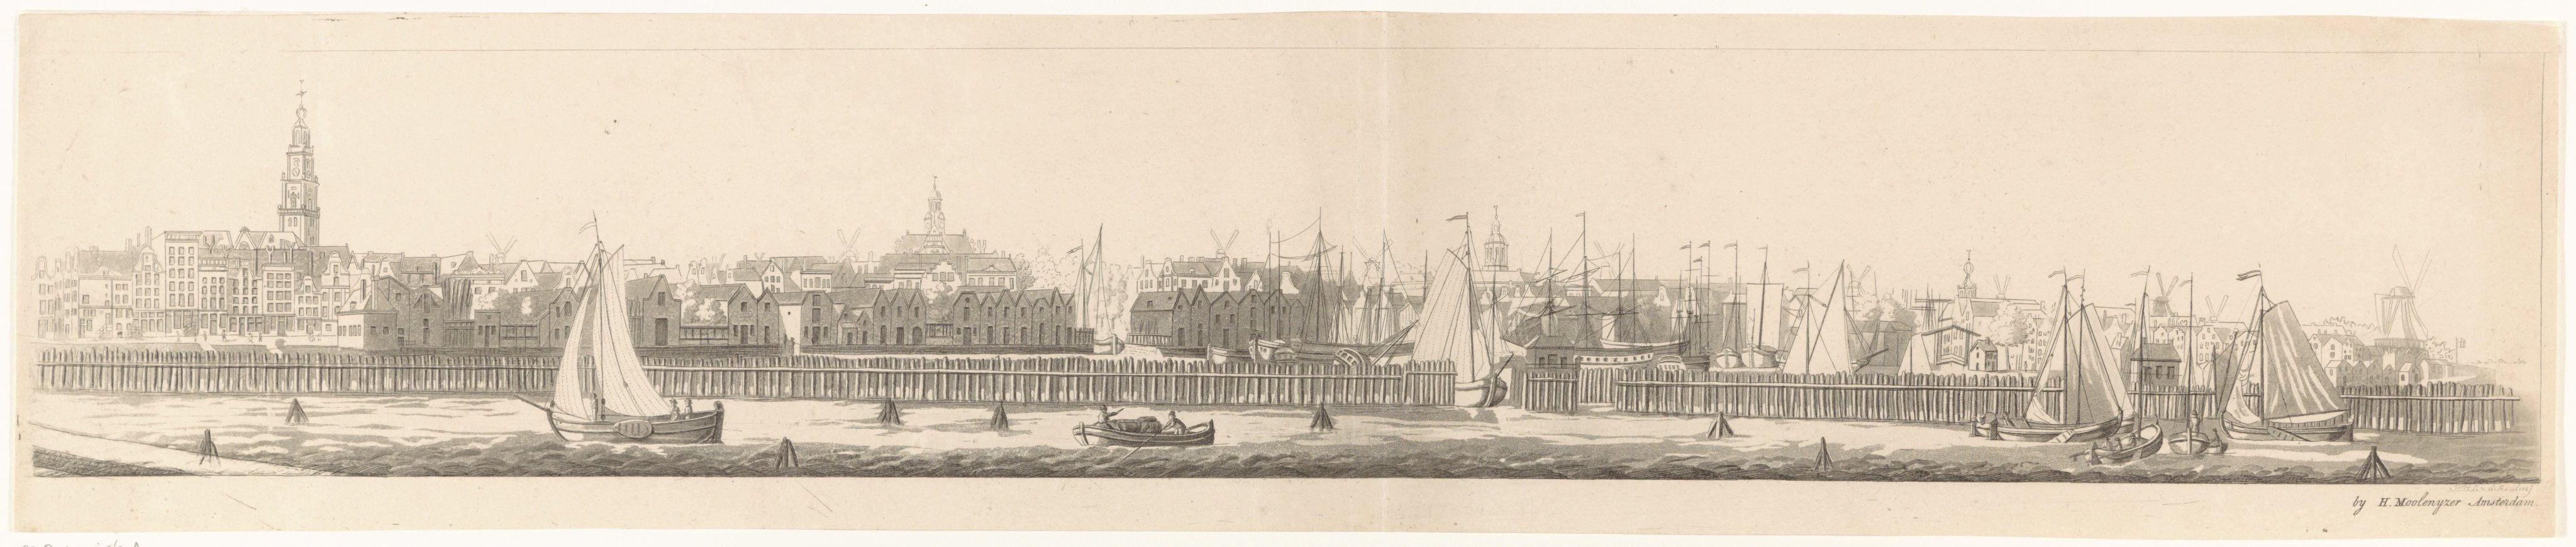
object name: print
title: Panorama van Amsterdam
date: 1792-1847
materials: paper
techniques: aquatint, engraving, etching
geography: amsterdam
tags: prospect of city, town panorama, silhouette of city, amsterdam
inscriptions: collector's mark: Lugt 2228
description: Gezicht vanaf het IJ op Amsterdam, met van links naar rechts de Westertoren en Noorderkerk. Op de voorgrond schepen.